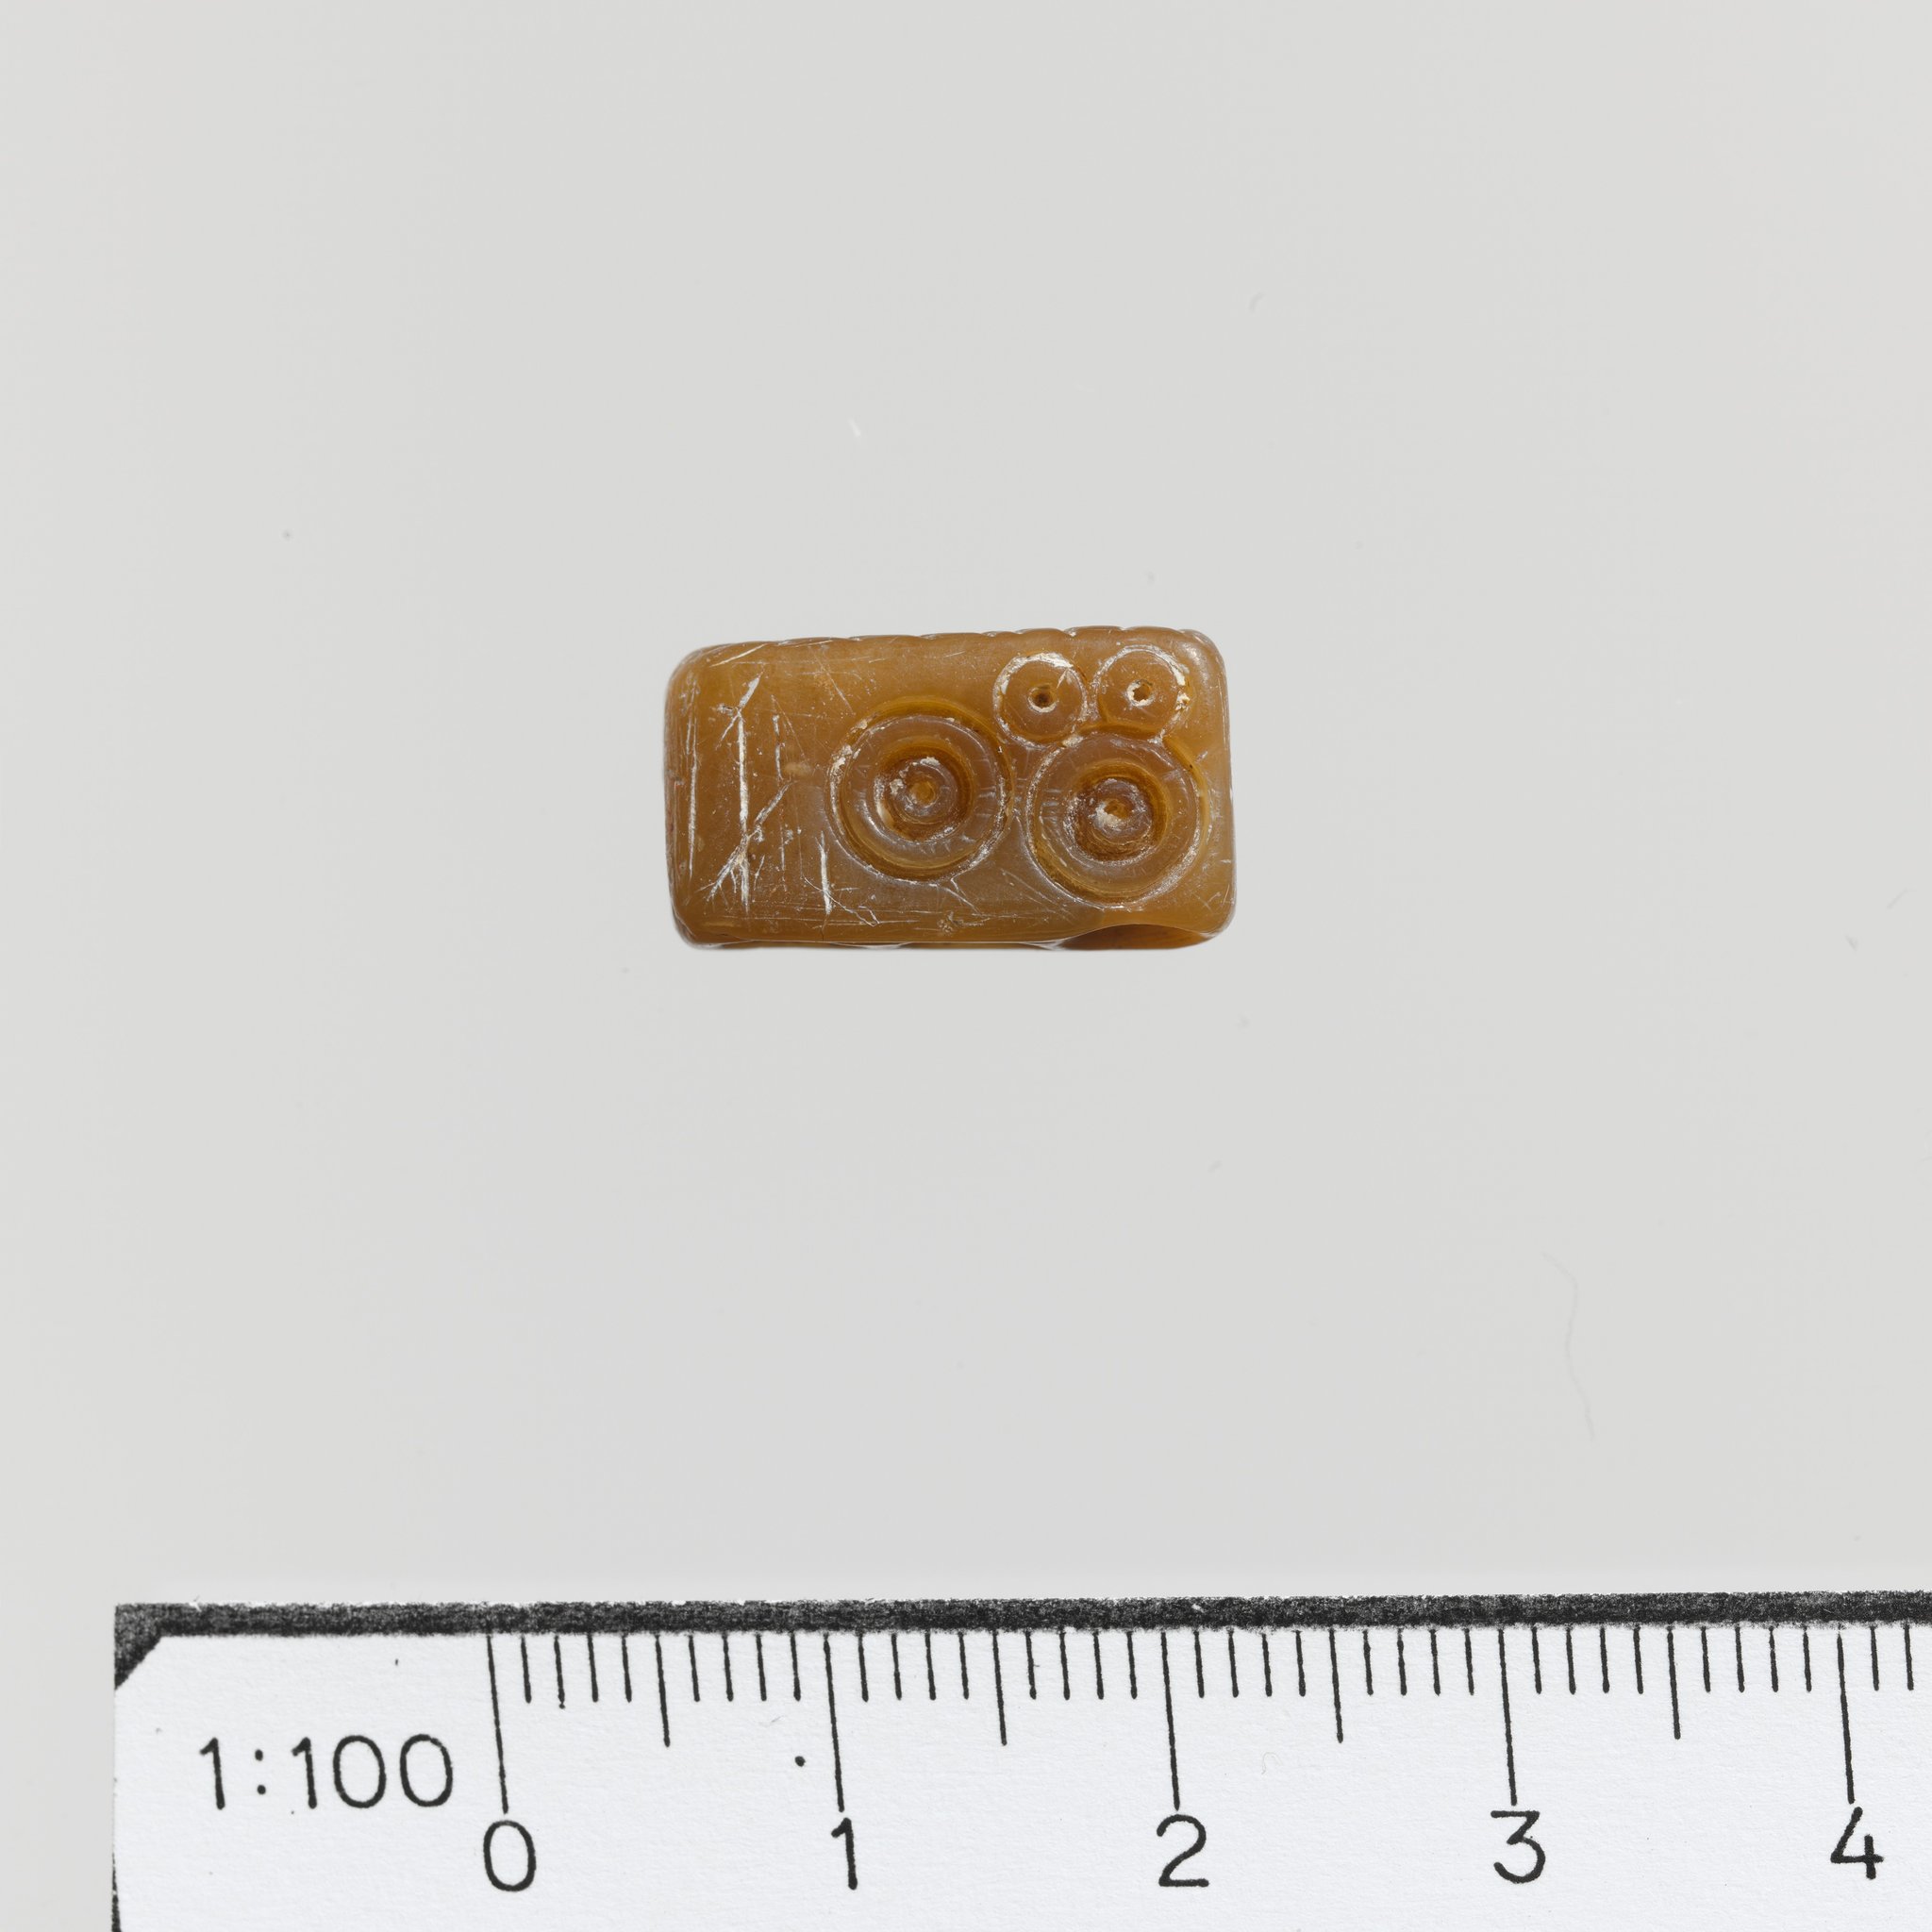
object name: seal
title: Steatite rectangular prism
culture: minoan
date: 1900-1750 BCE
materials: stone